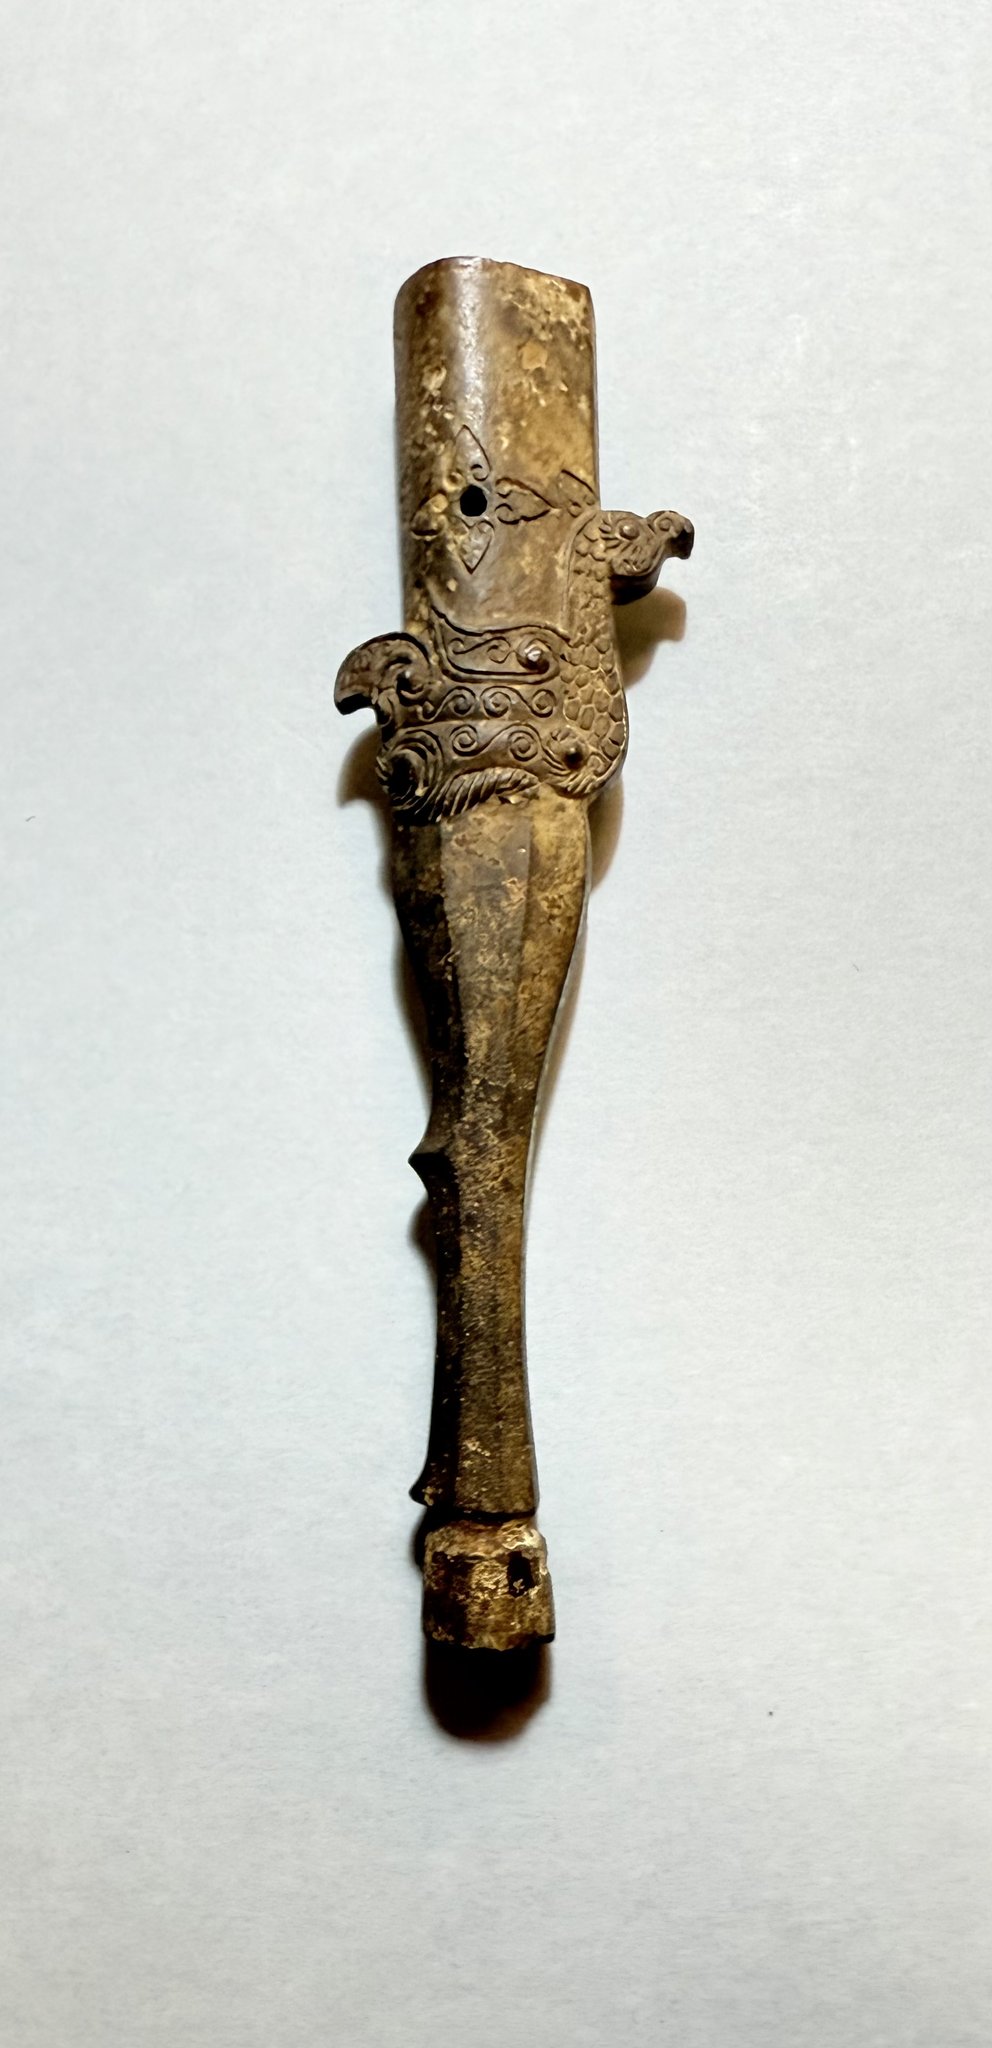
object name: ferrule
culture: chinese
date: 400-201 BCE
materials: bronze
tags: birds